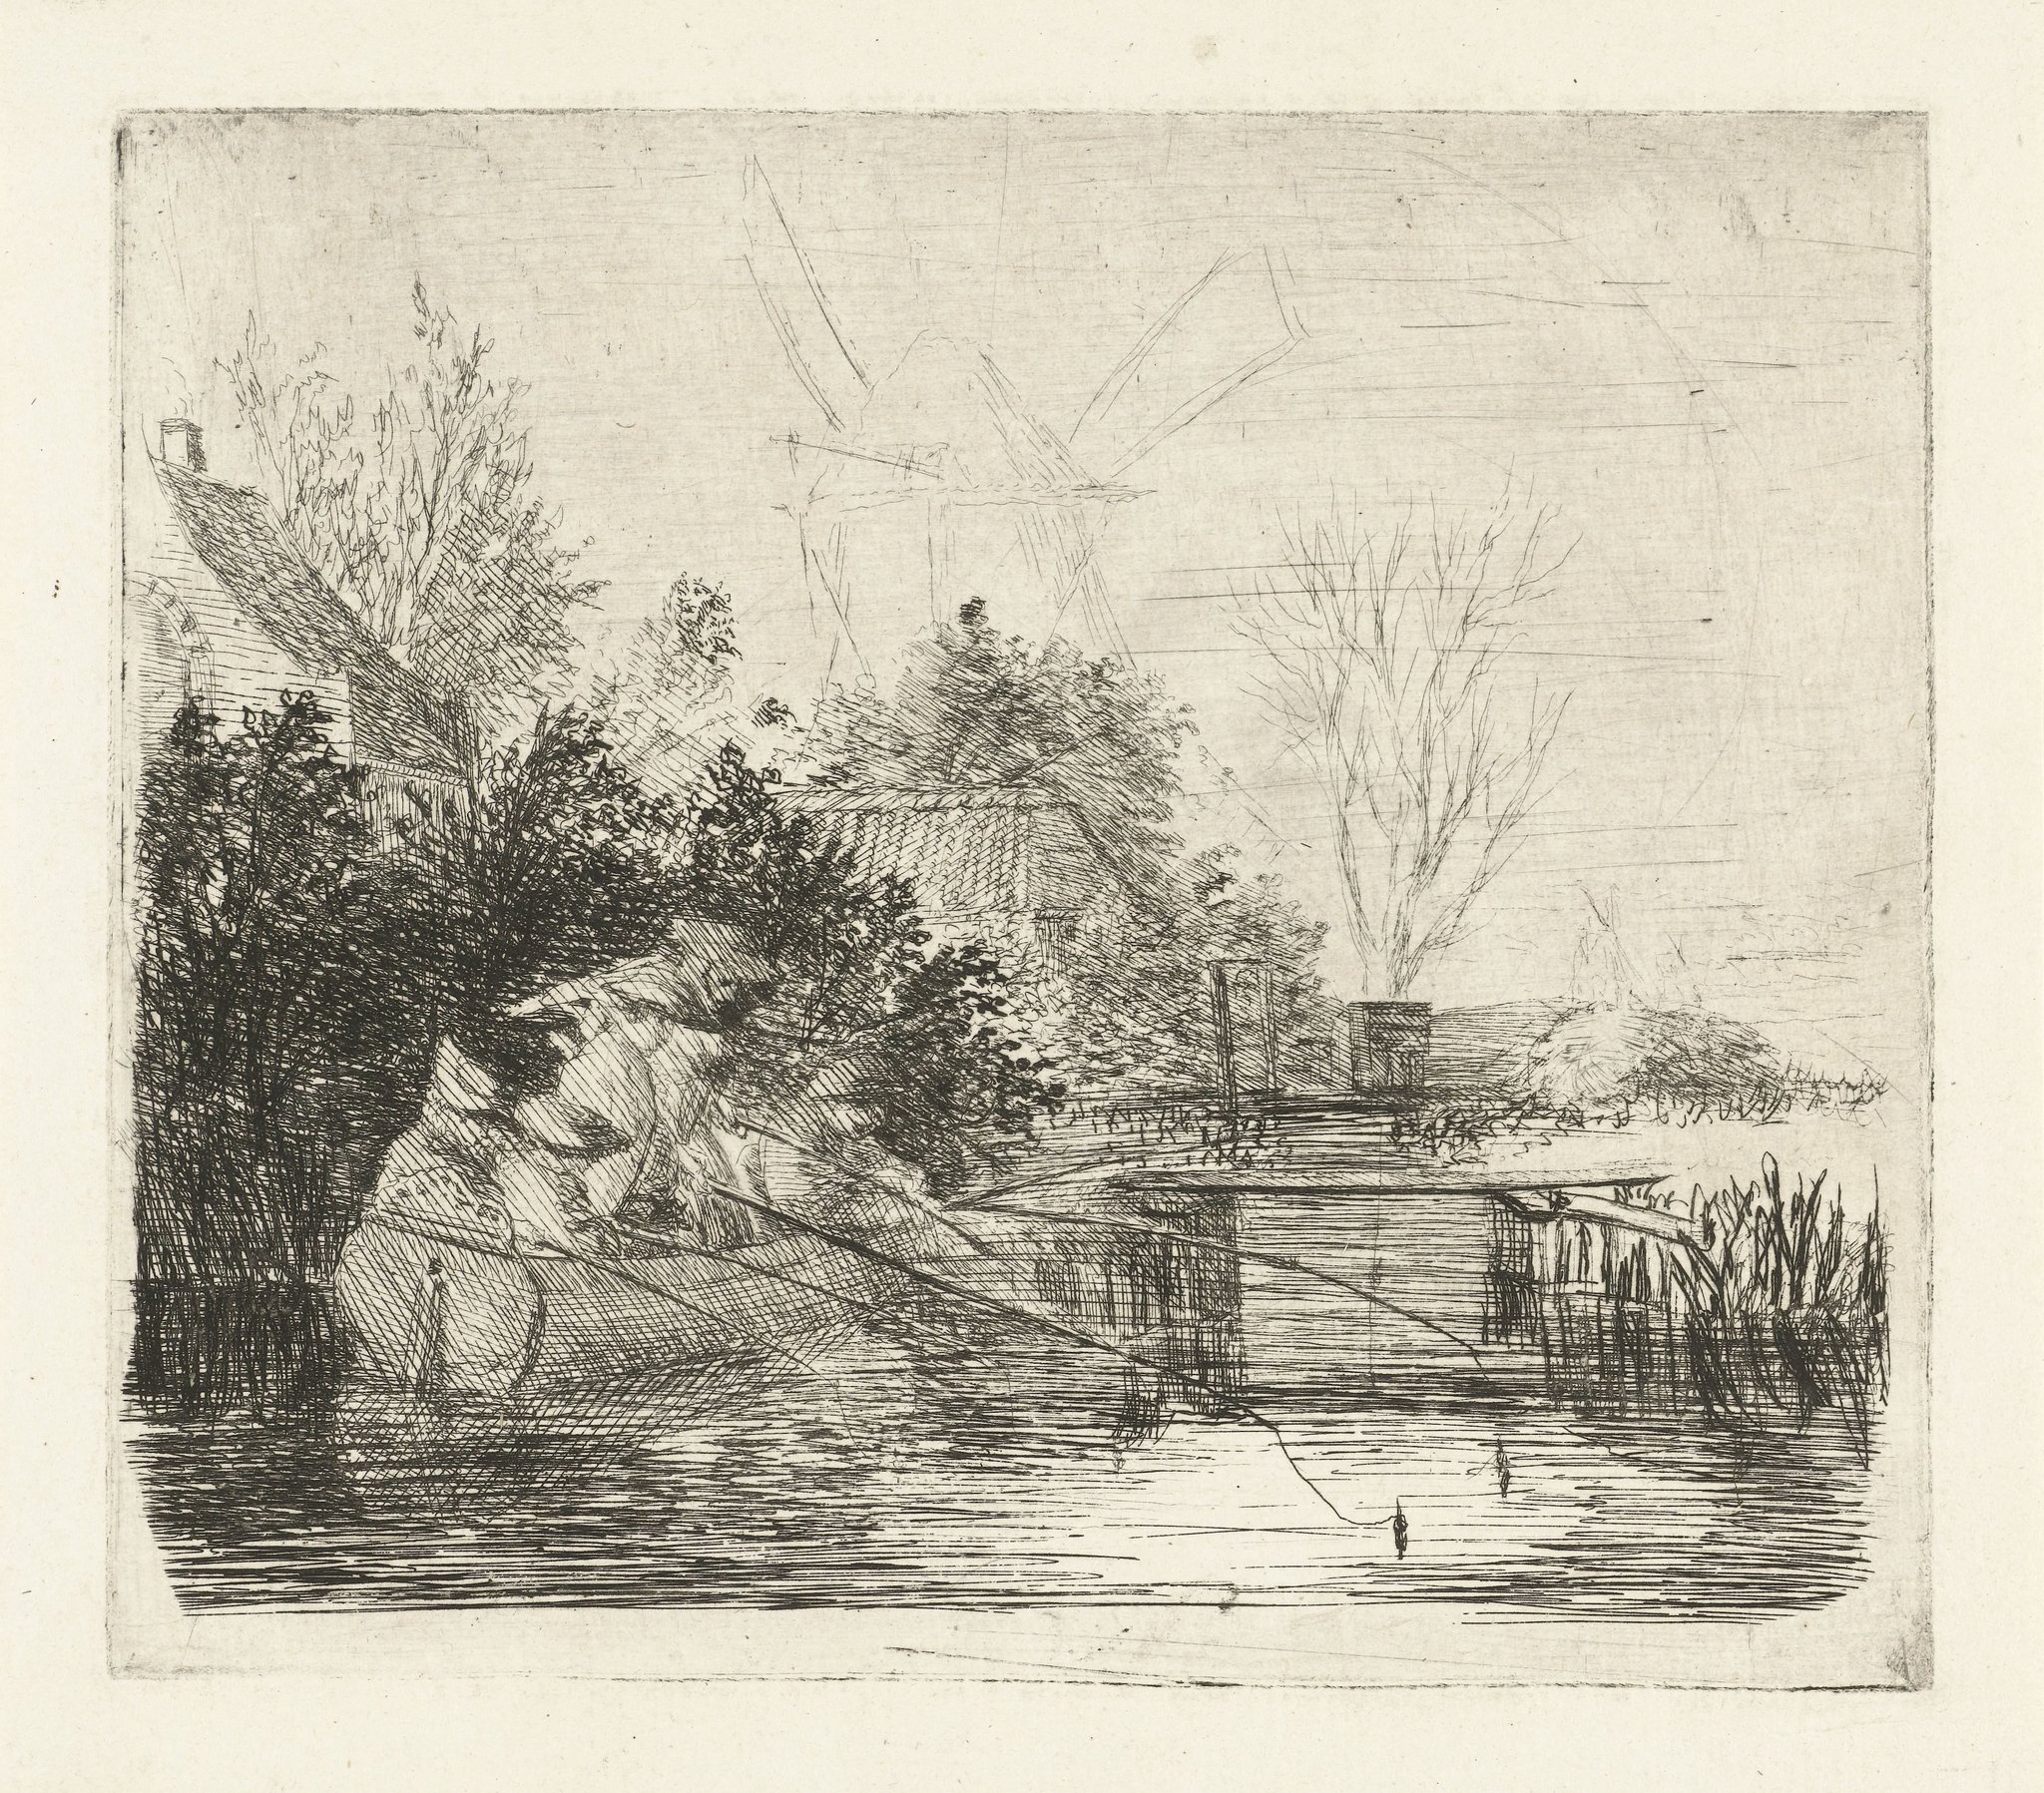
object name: print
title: Hengelaars bij een rivier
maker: louis bernard coclers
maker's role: draughtsman, print maker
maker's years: 1741-1817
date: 1756-1817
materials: paper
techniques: drypoint, etching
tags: fresh-water fishery, rowing-boat, canoe, etc.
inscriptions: collector's mark: Lugt 2228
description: Een groepje mannen vist vanuit een bootje in een rivier. Op de achtergrond een brug en de omtrek van een molen.